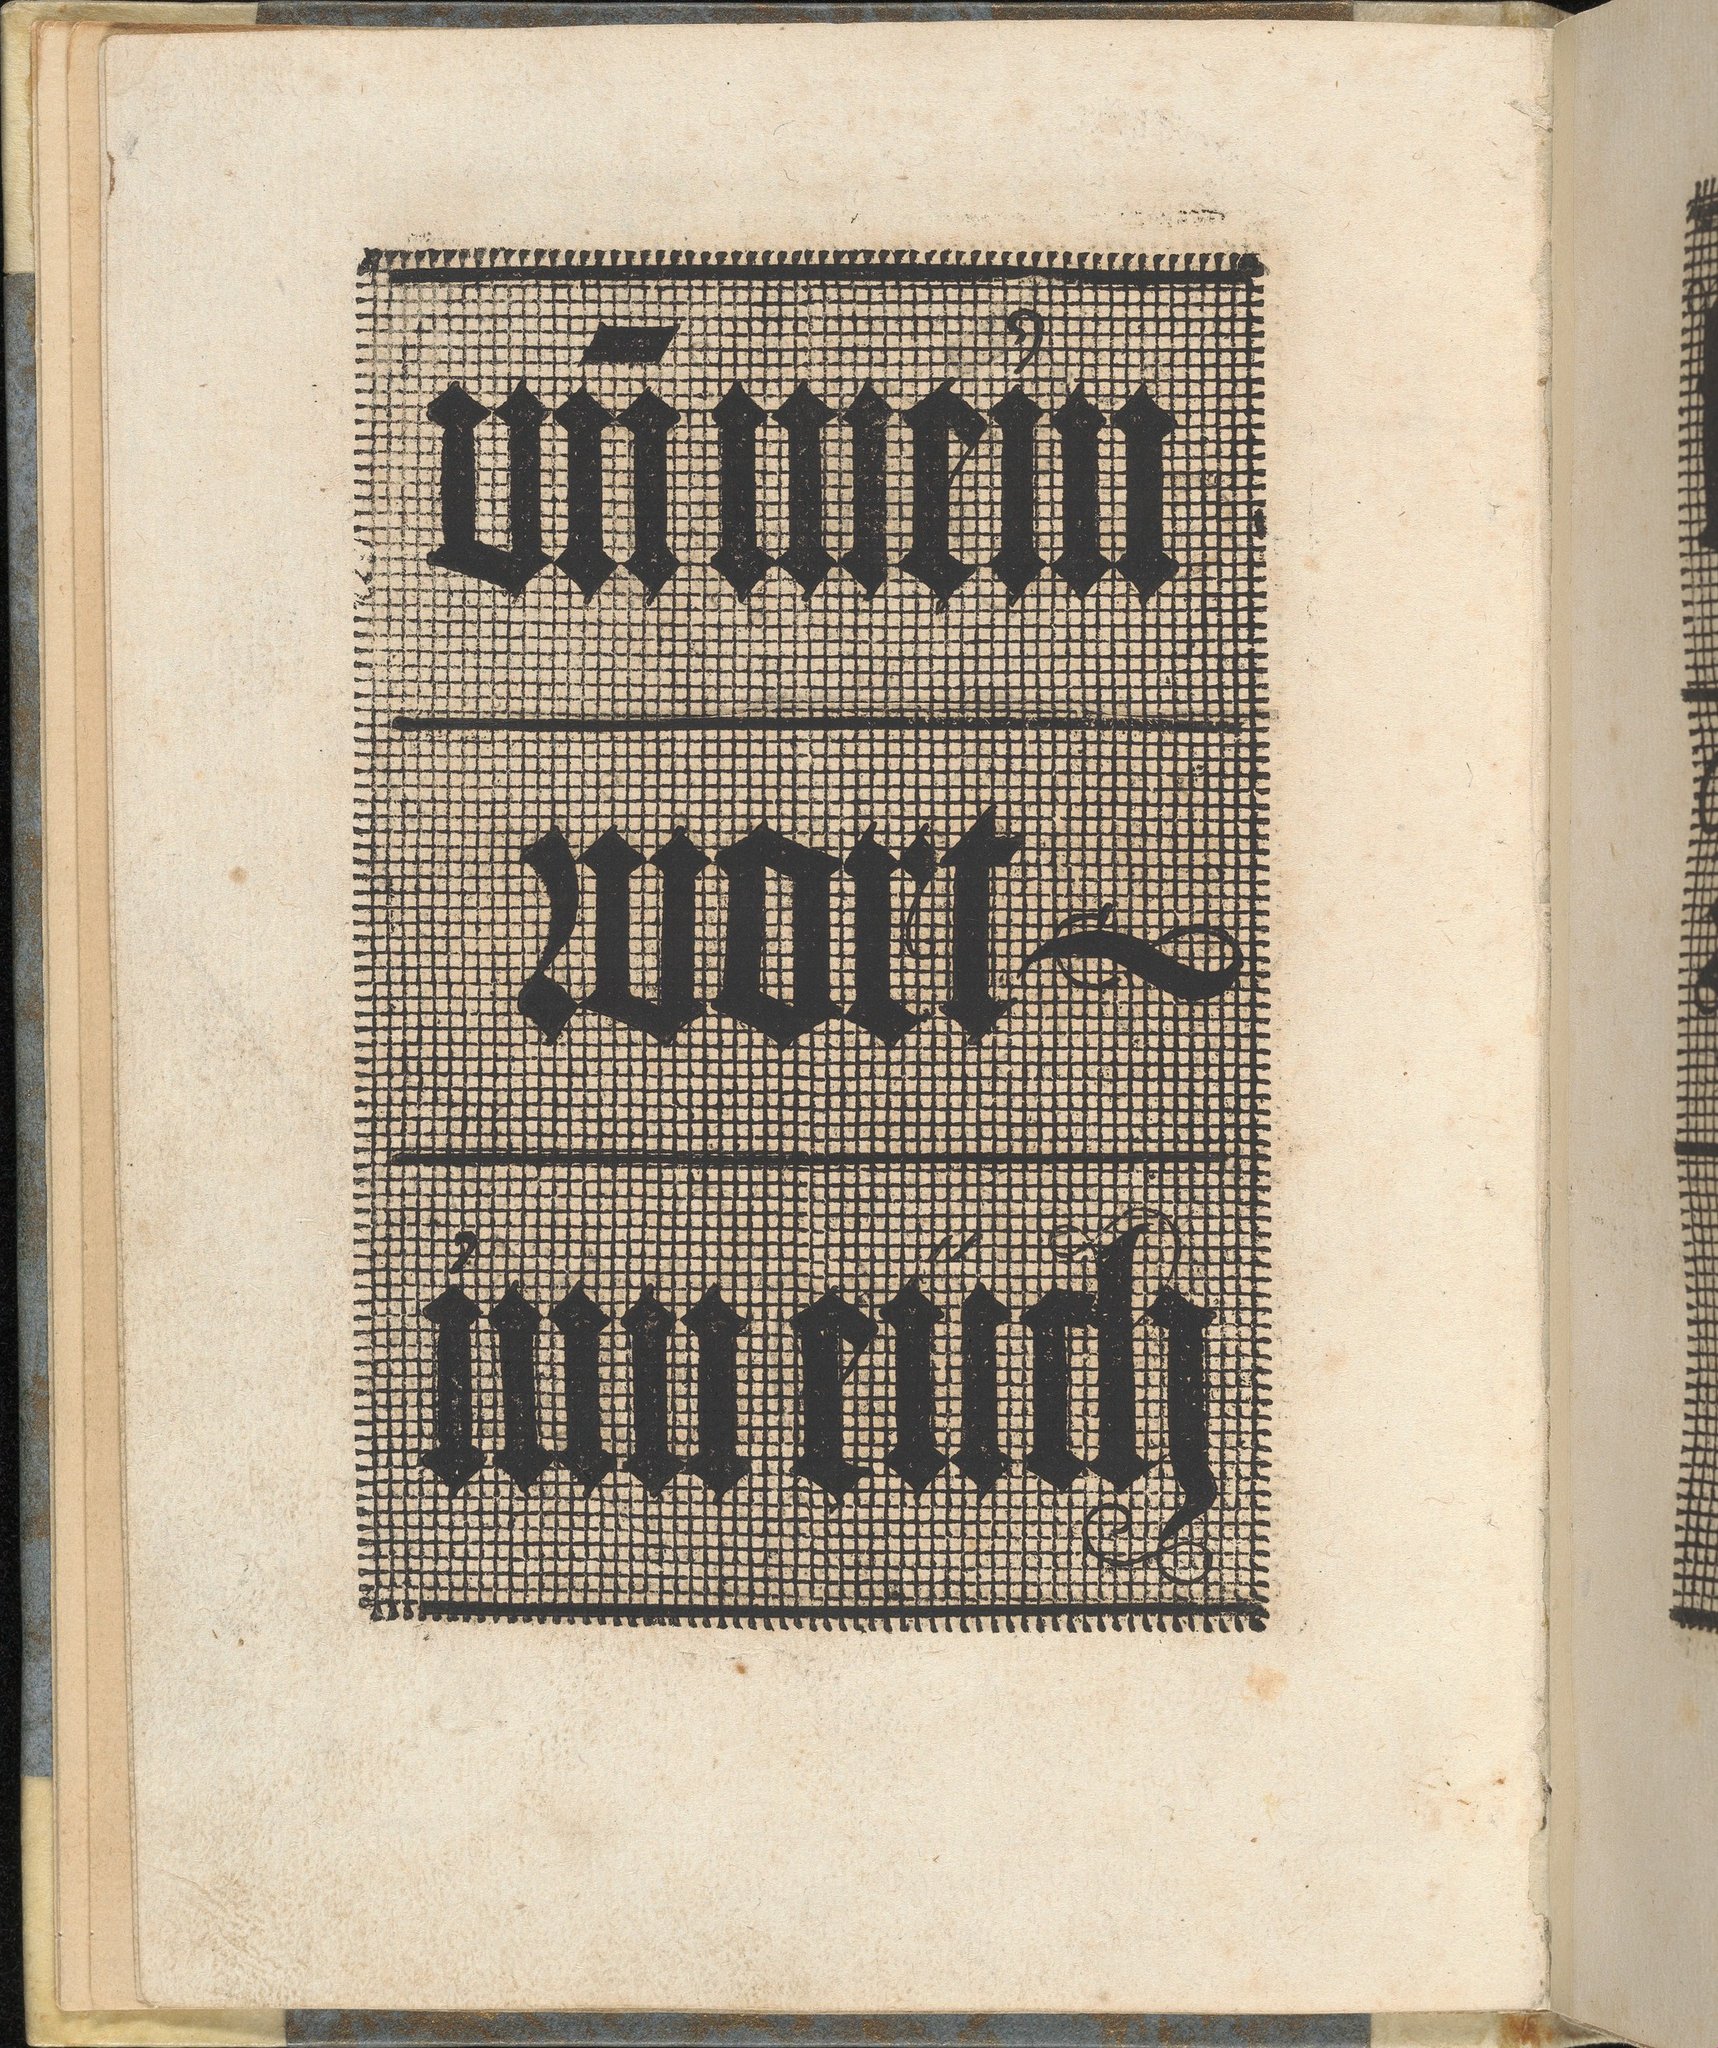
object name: book print ornament architecture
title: Ein ney Furmbüchlein, Page 3, verso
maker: johann schönsperger the younger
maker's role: publisher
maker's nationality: german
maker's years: 1490-1550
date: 1525-1529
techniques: woodcut